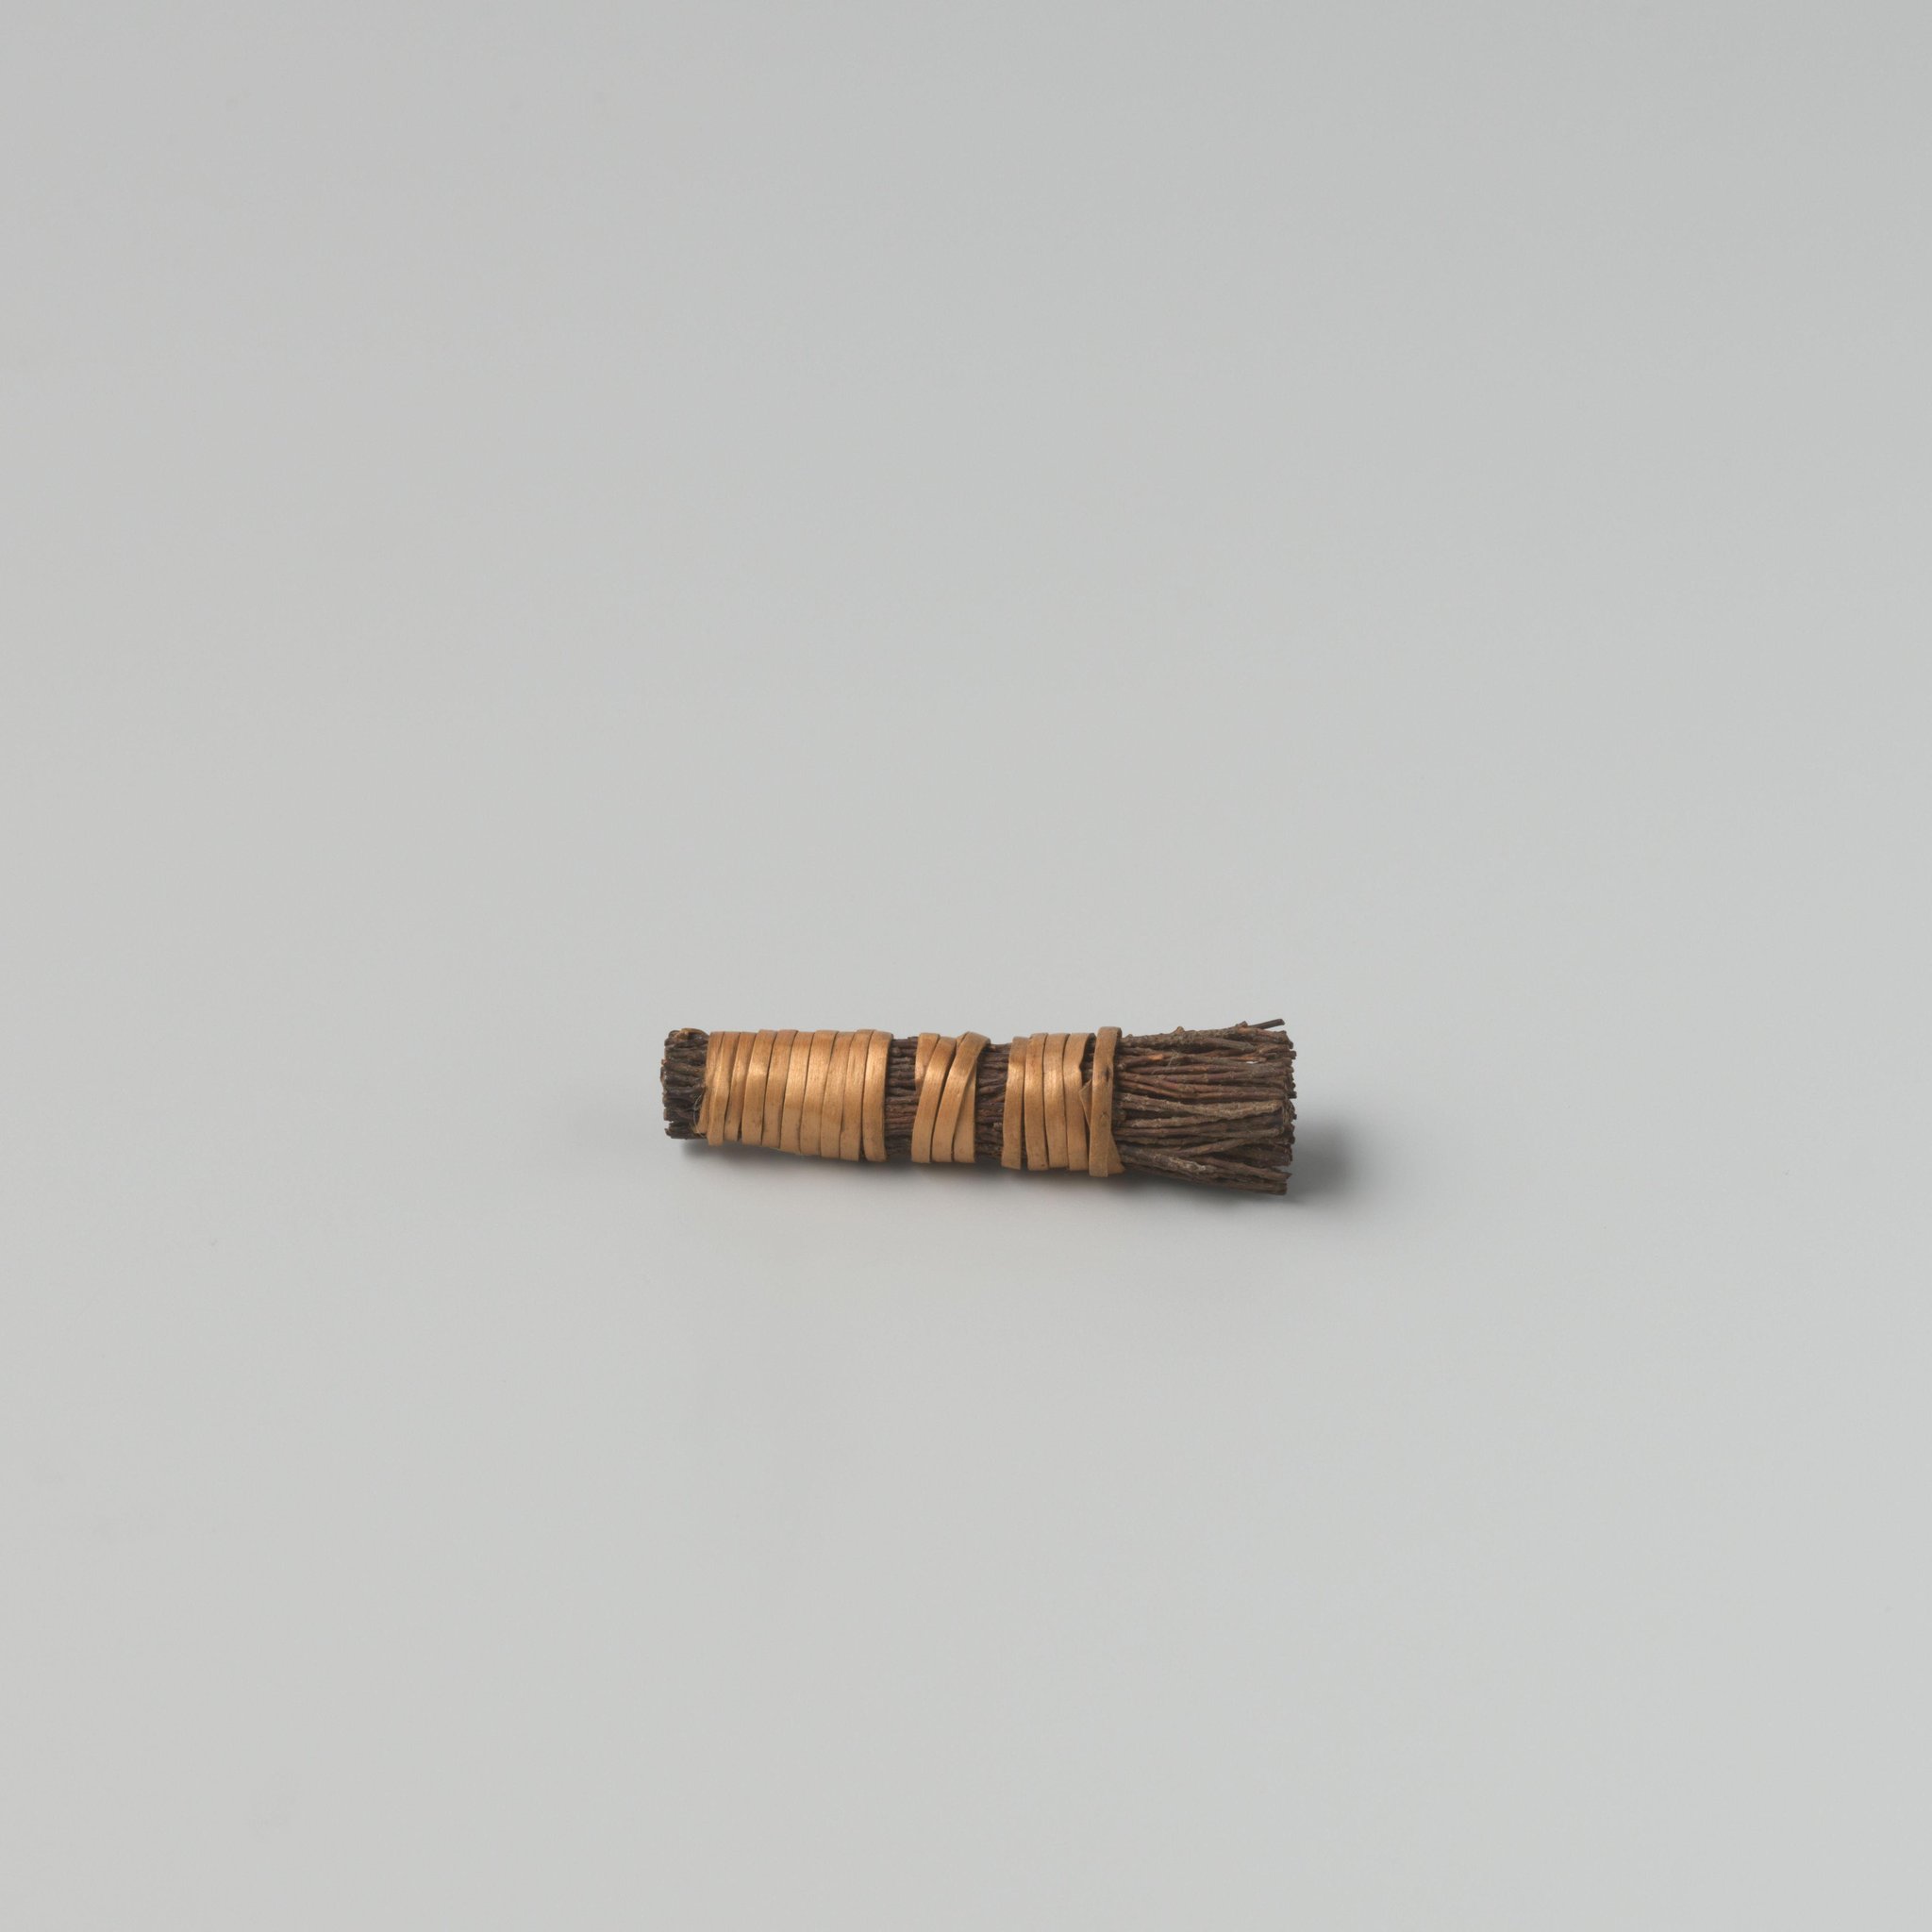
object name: miniature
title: Boender bestaande uit een takkebos, samengebonden door wilgenteen.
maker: Anonymous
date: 1700-1710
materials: plant material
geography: amsterdam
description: Boender bestaande uit een takkebos, samengebonden door wilgenteen.